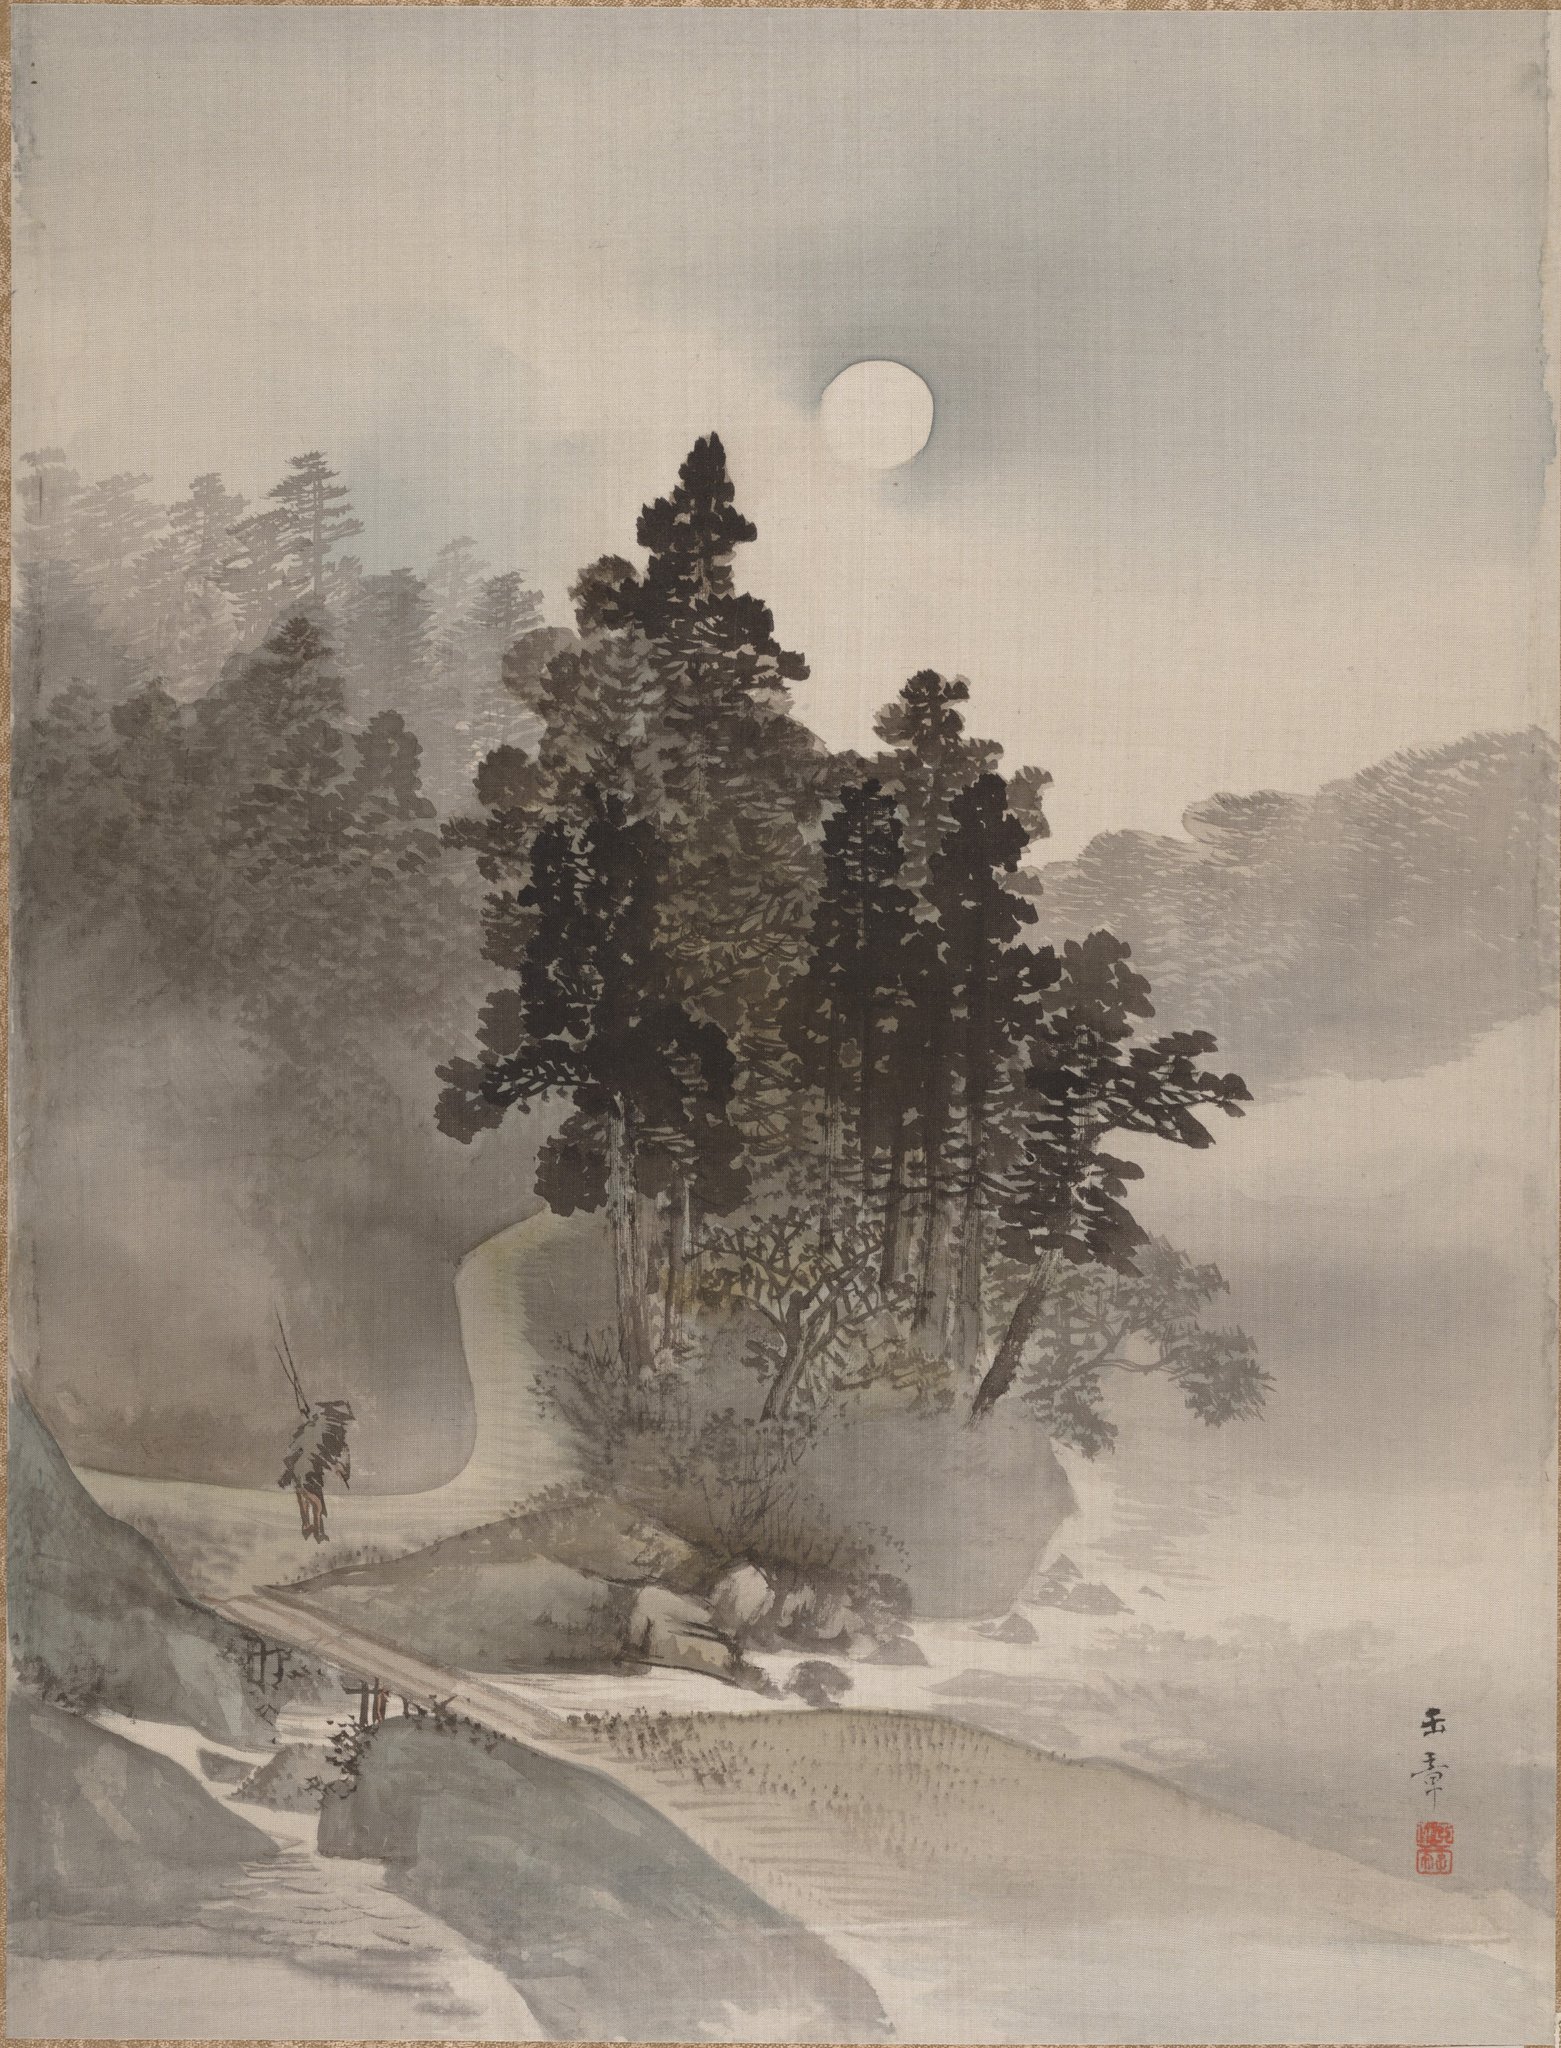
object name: album leaf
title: Traveling by Moonlight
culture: japanese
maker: kawabata gyokushō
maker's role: artist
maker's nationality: japanese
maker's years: 1842-1913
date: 1887-1892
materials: ink, silk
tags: roads,moon,trees,night